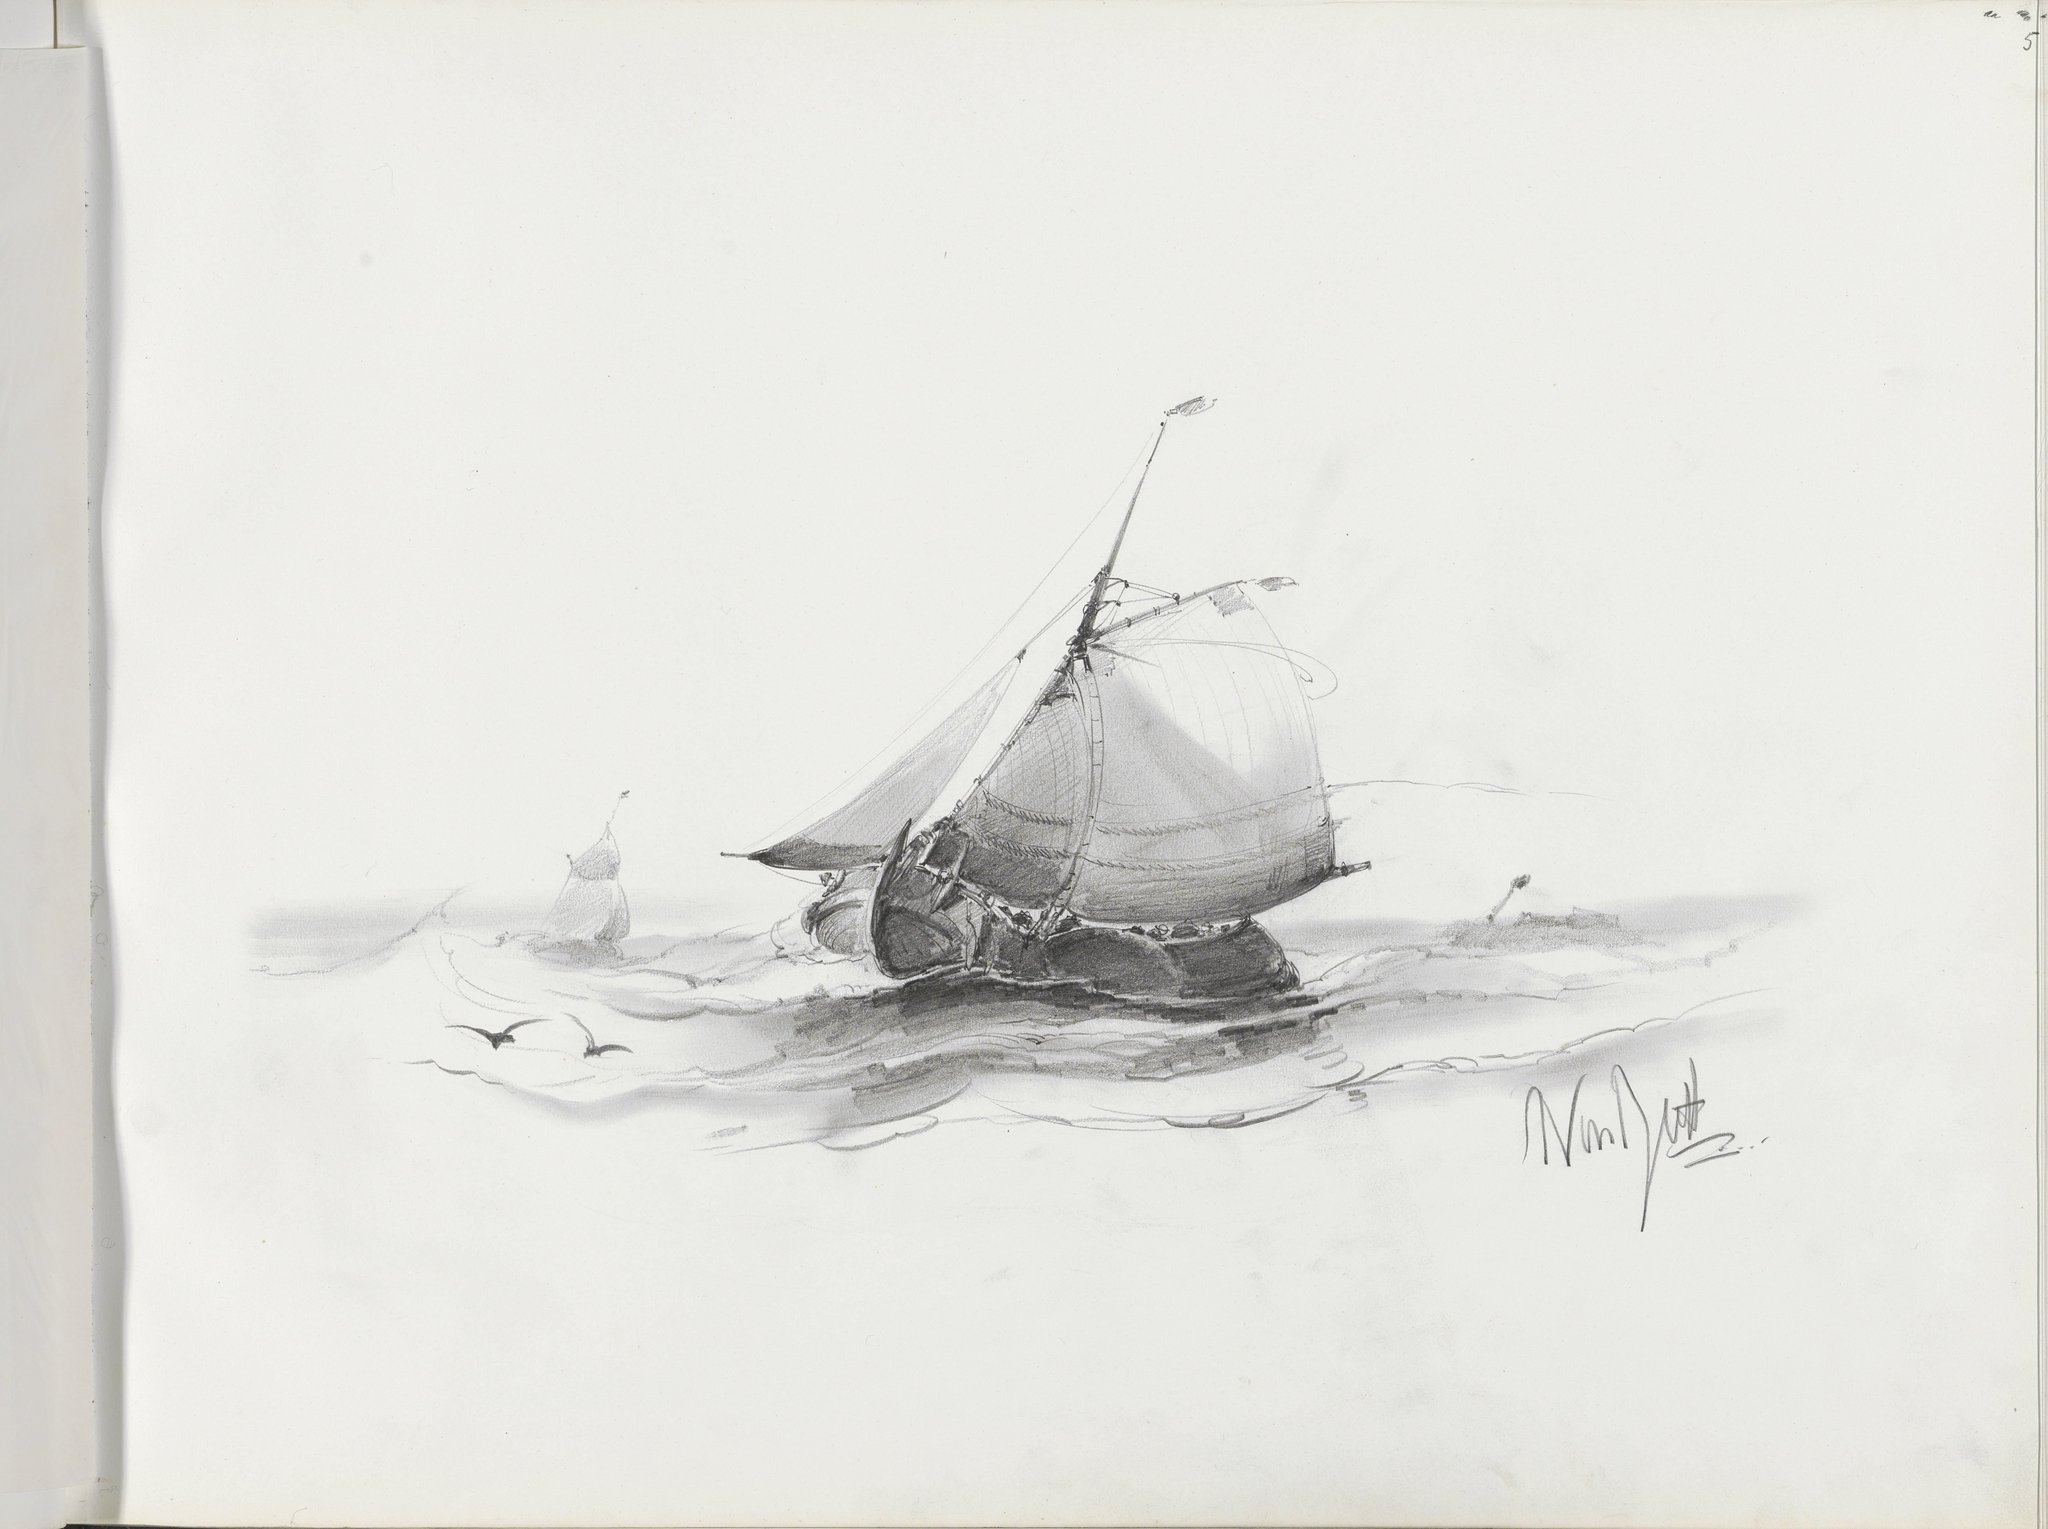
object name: sketchbook leaf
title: Bomschuit op het water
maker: albertus van beest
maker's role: draughtsman, print maker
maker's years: 1820-1860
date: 1830-1860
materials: paper, pencil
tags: sailing-ship, sailing-boat, landscapes with waters, waterscapes, seascapes (in the temperate zone)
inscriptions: signature: ‘AVan Beest’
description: Blad 5 recto uit een schetsboek met 46 bladen.